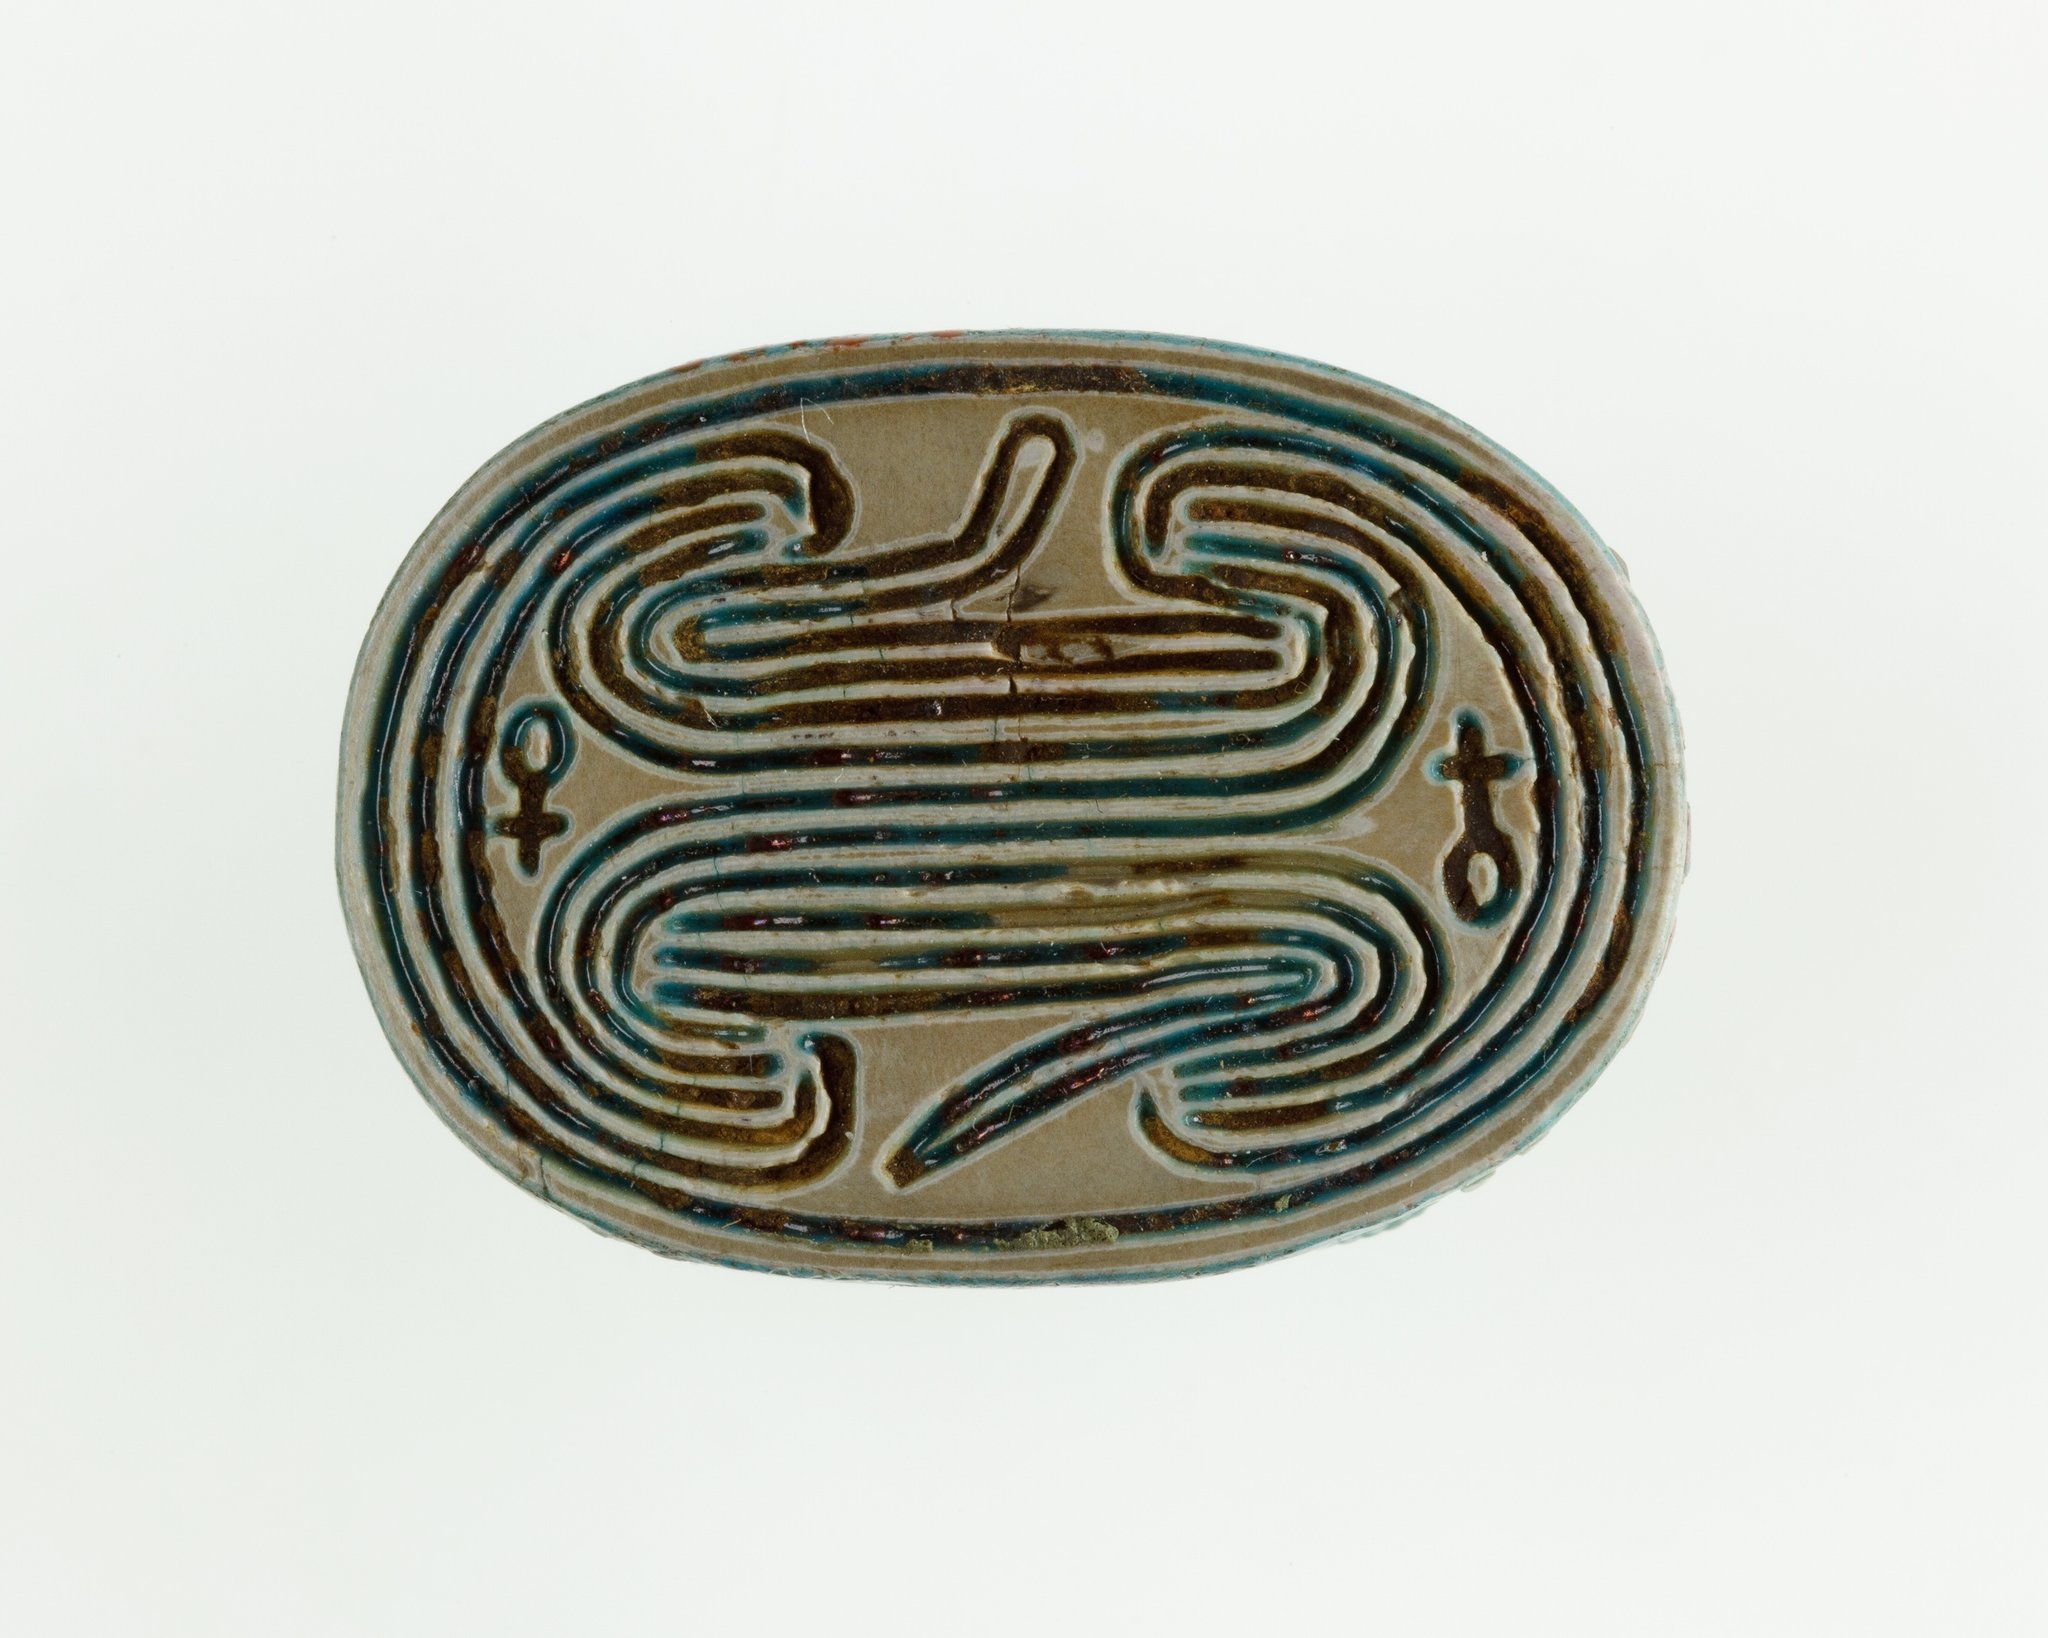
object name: scarab, hatnefer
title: Scarab of Hatnefer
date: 1492-1473 BCE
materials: stone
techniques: glazing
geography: egypt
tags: scarabs